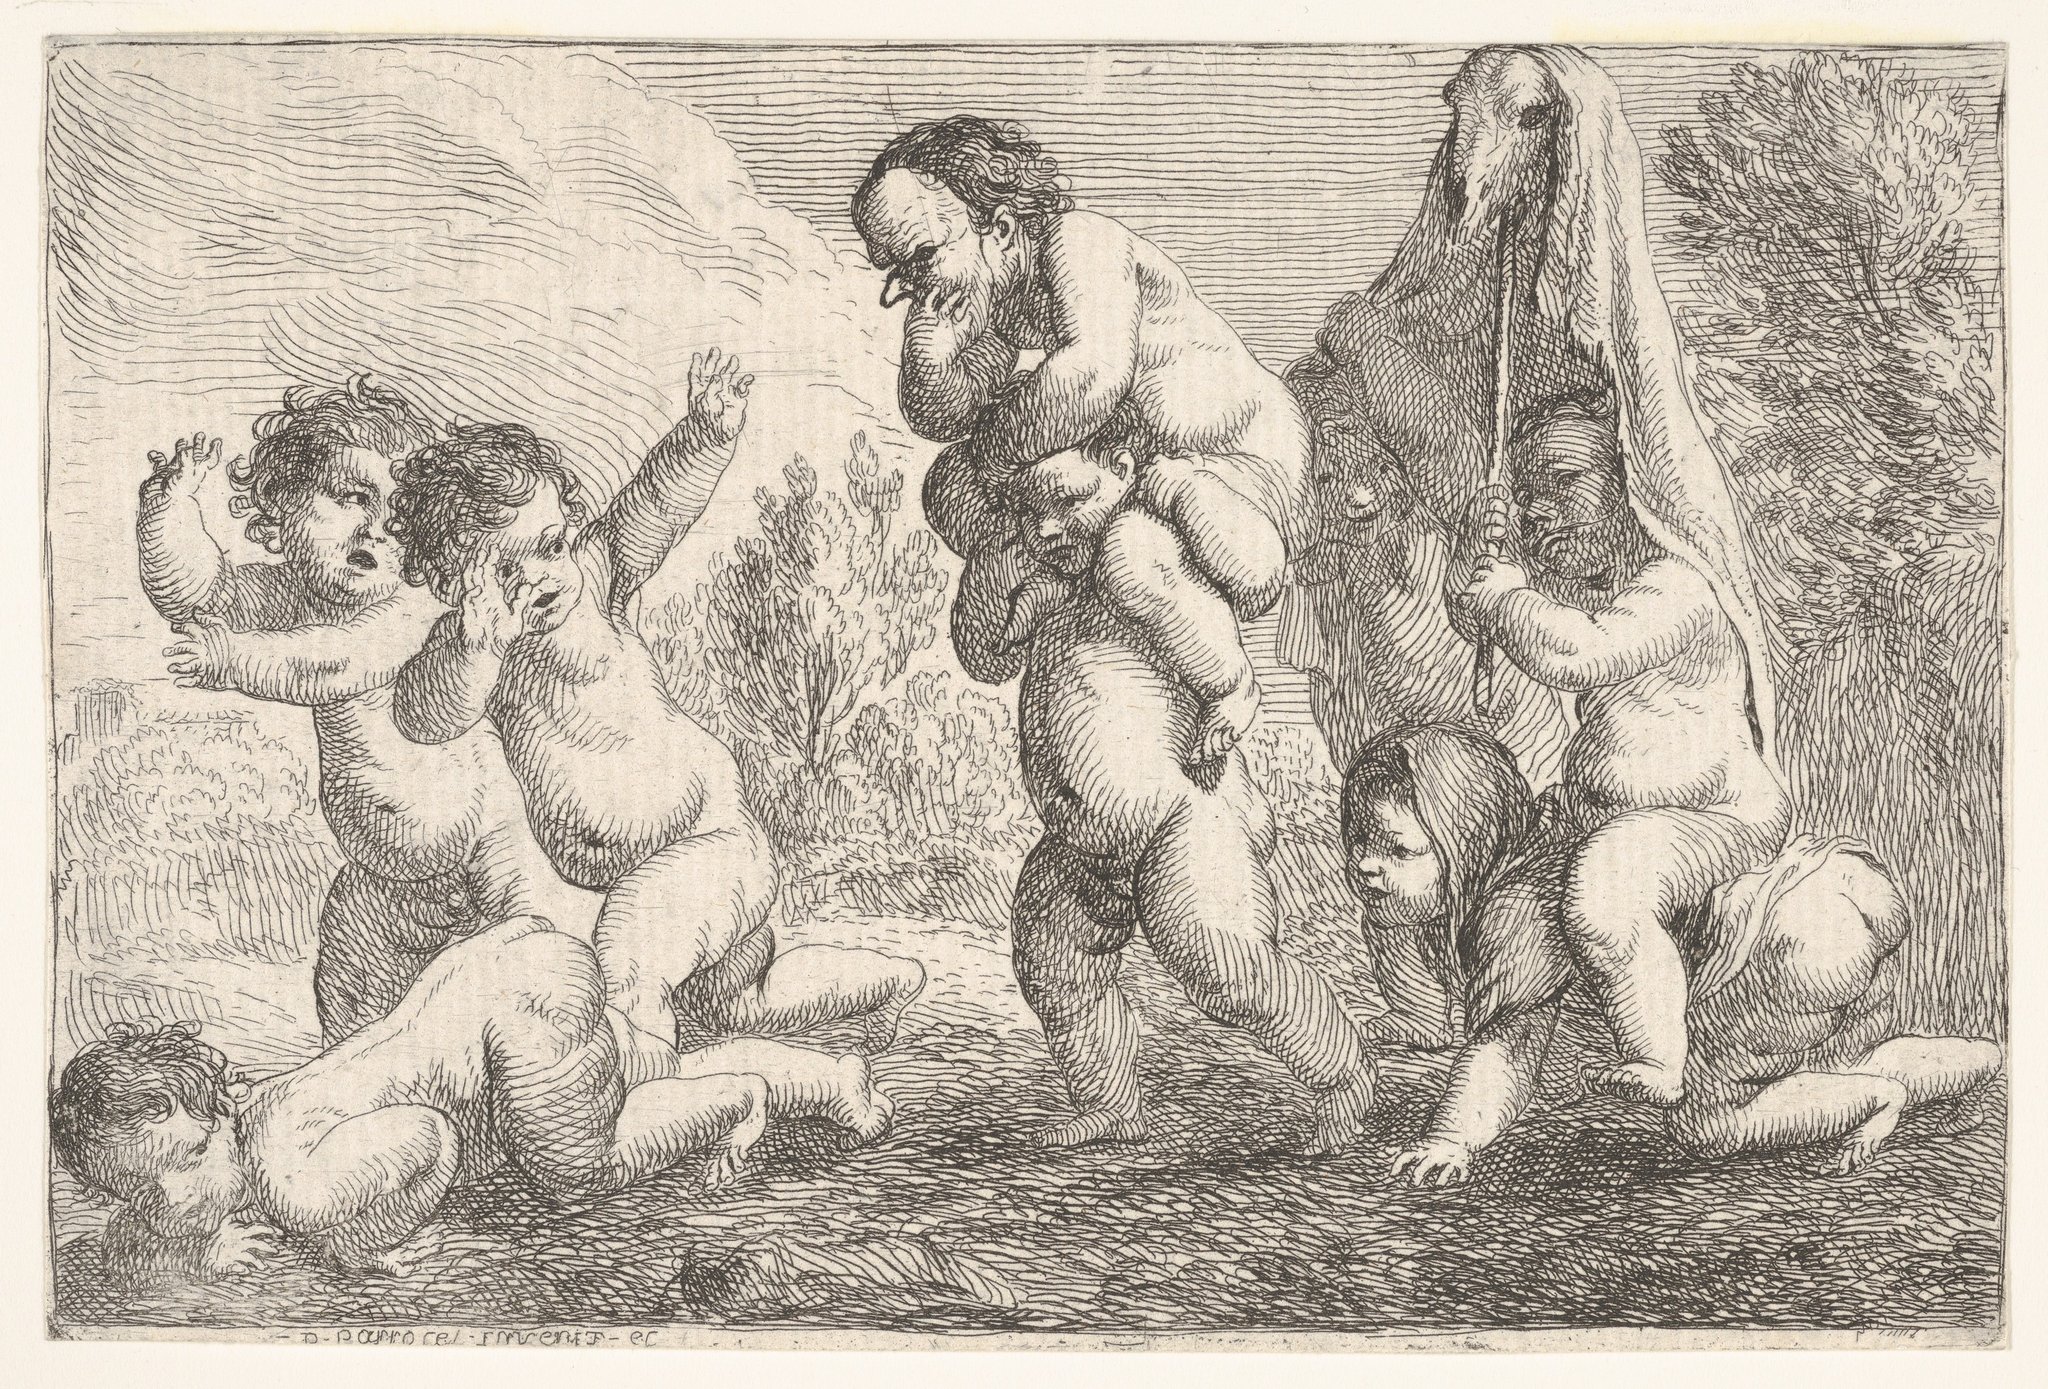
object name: print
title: Children's Game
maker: pierre parrocel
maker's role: artist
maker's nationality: french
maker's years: 1664-1739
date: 1601-1800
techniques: etching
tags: children,playing